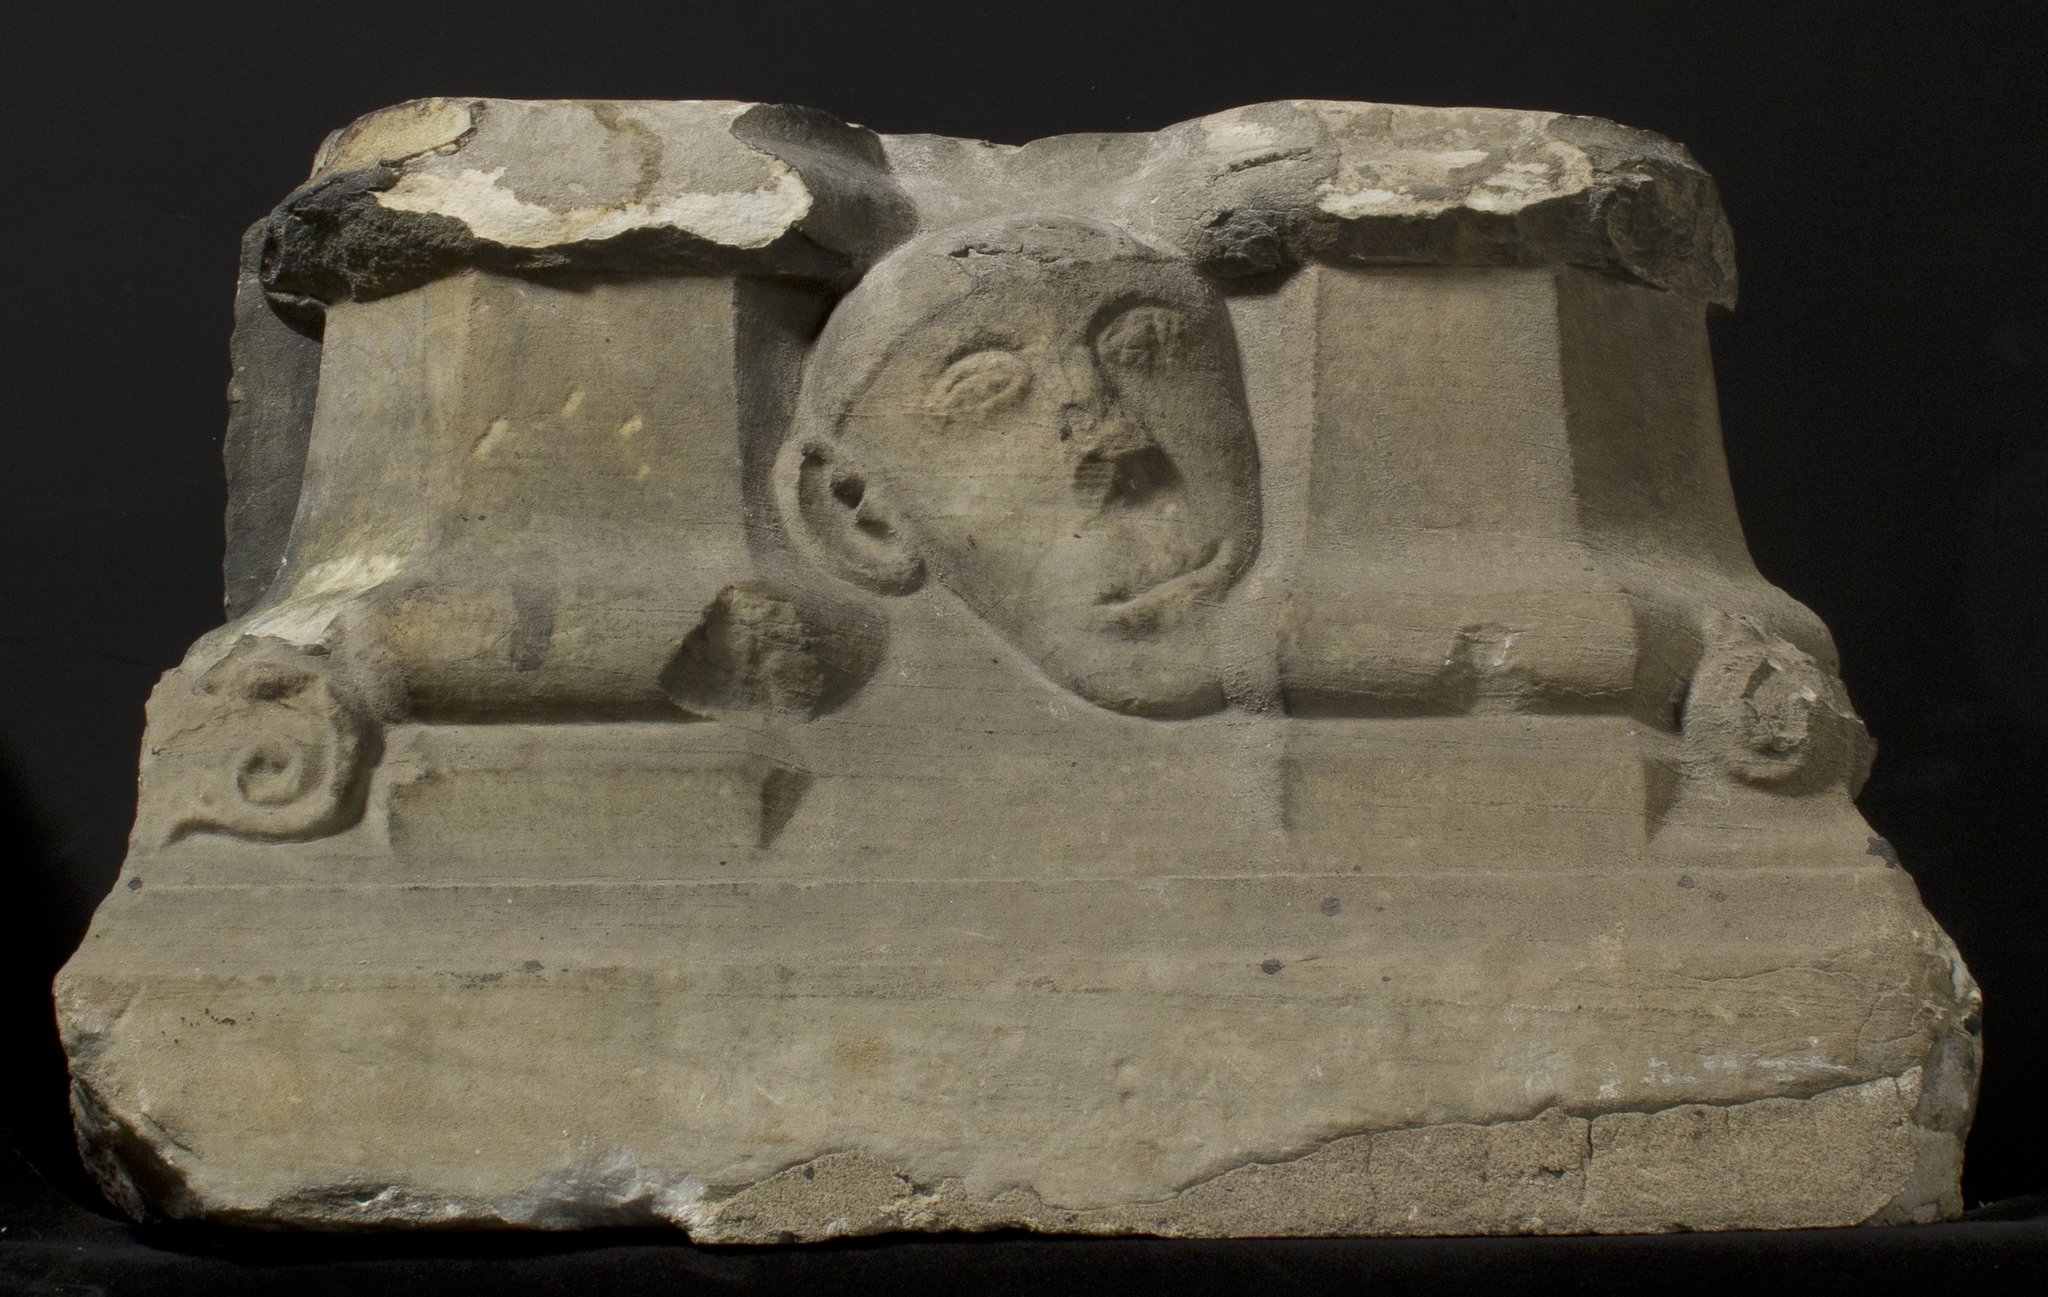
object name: base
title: Engaged Double Base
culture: french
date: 1467-1500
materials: marble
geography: france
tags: faces